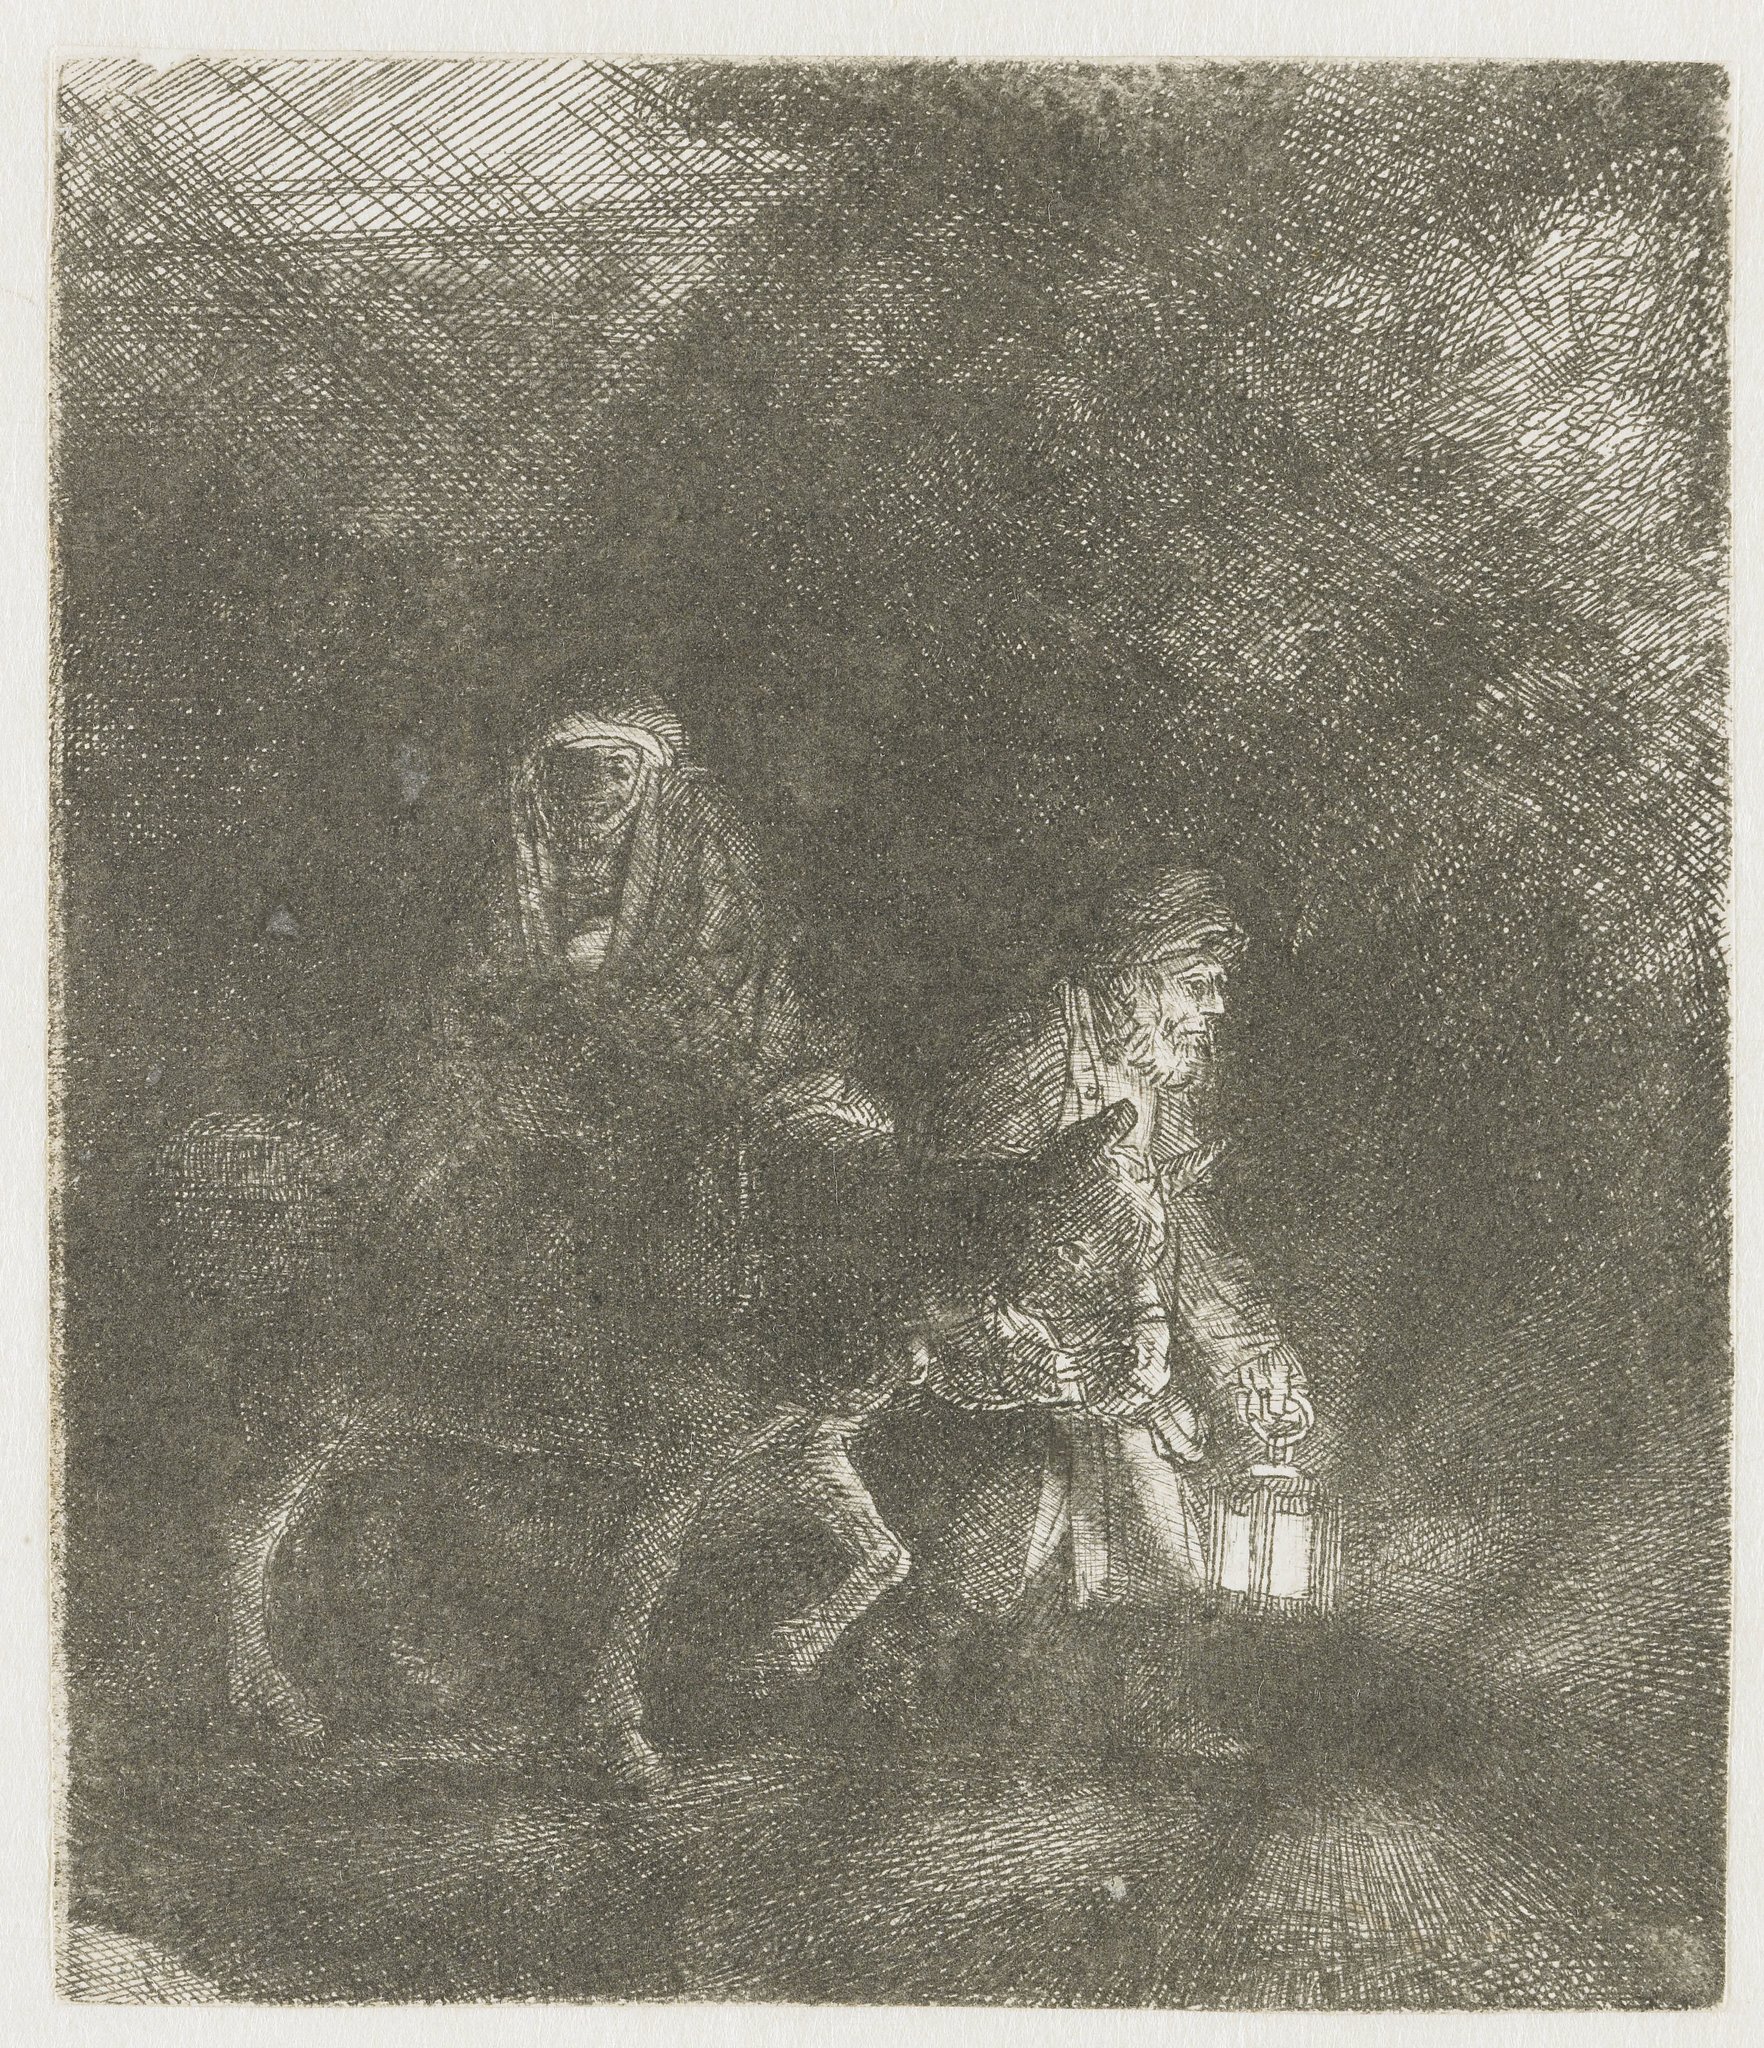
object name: print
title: The flight into Egypt: a night piece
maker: rembrandt van rijn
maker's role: draughtsman, painter, print maker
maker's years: 1606-1669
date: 1651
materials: paper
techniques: printmaking, drypoint, etching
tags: the flight into egypt: mary, joseph, the child (and sometimes others) on their way; mary usually riding on an ass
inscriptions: signature and date: ‘Rembrandt f. 1651 (in spiegelbeeld)’, collector's mark: Lugt 240